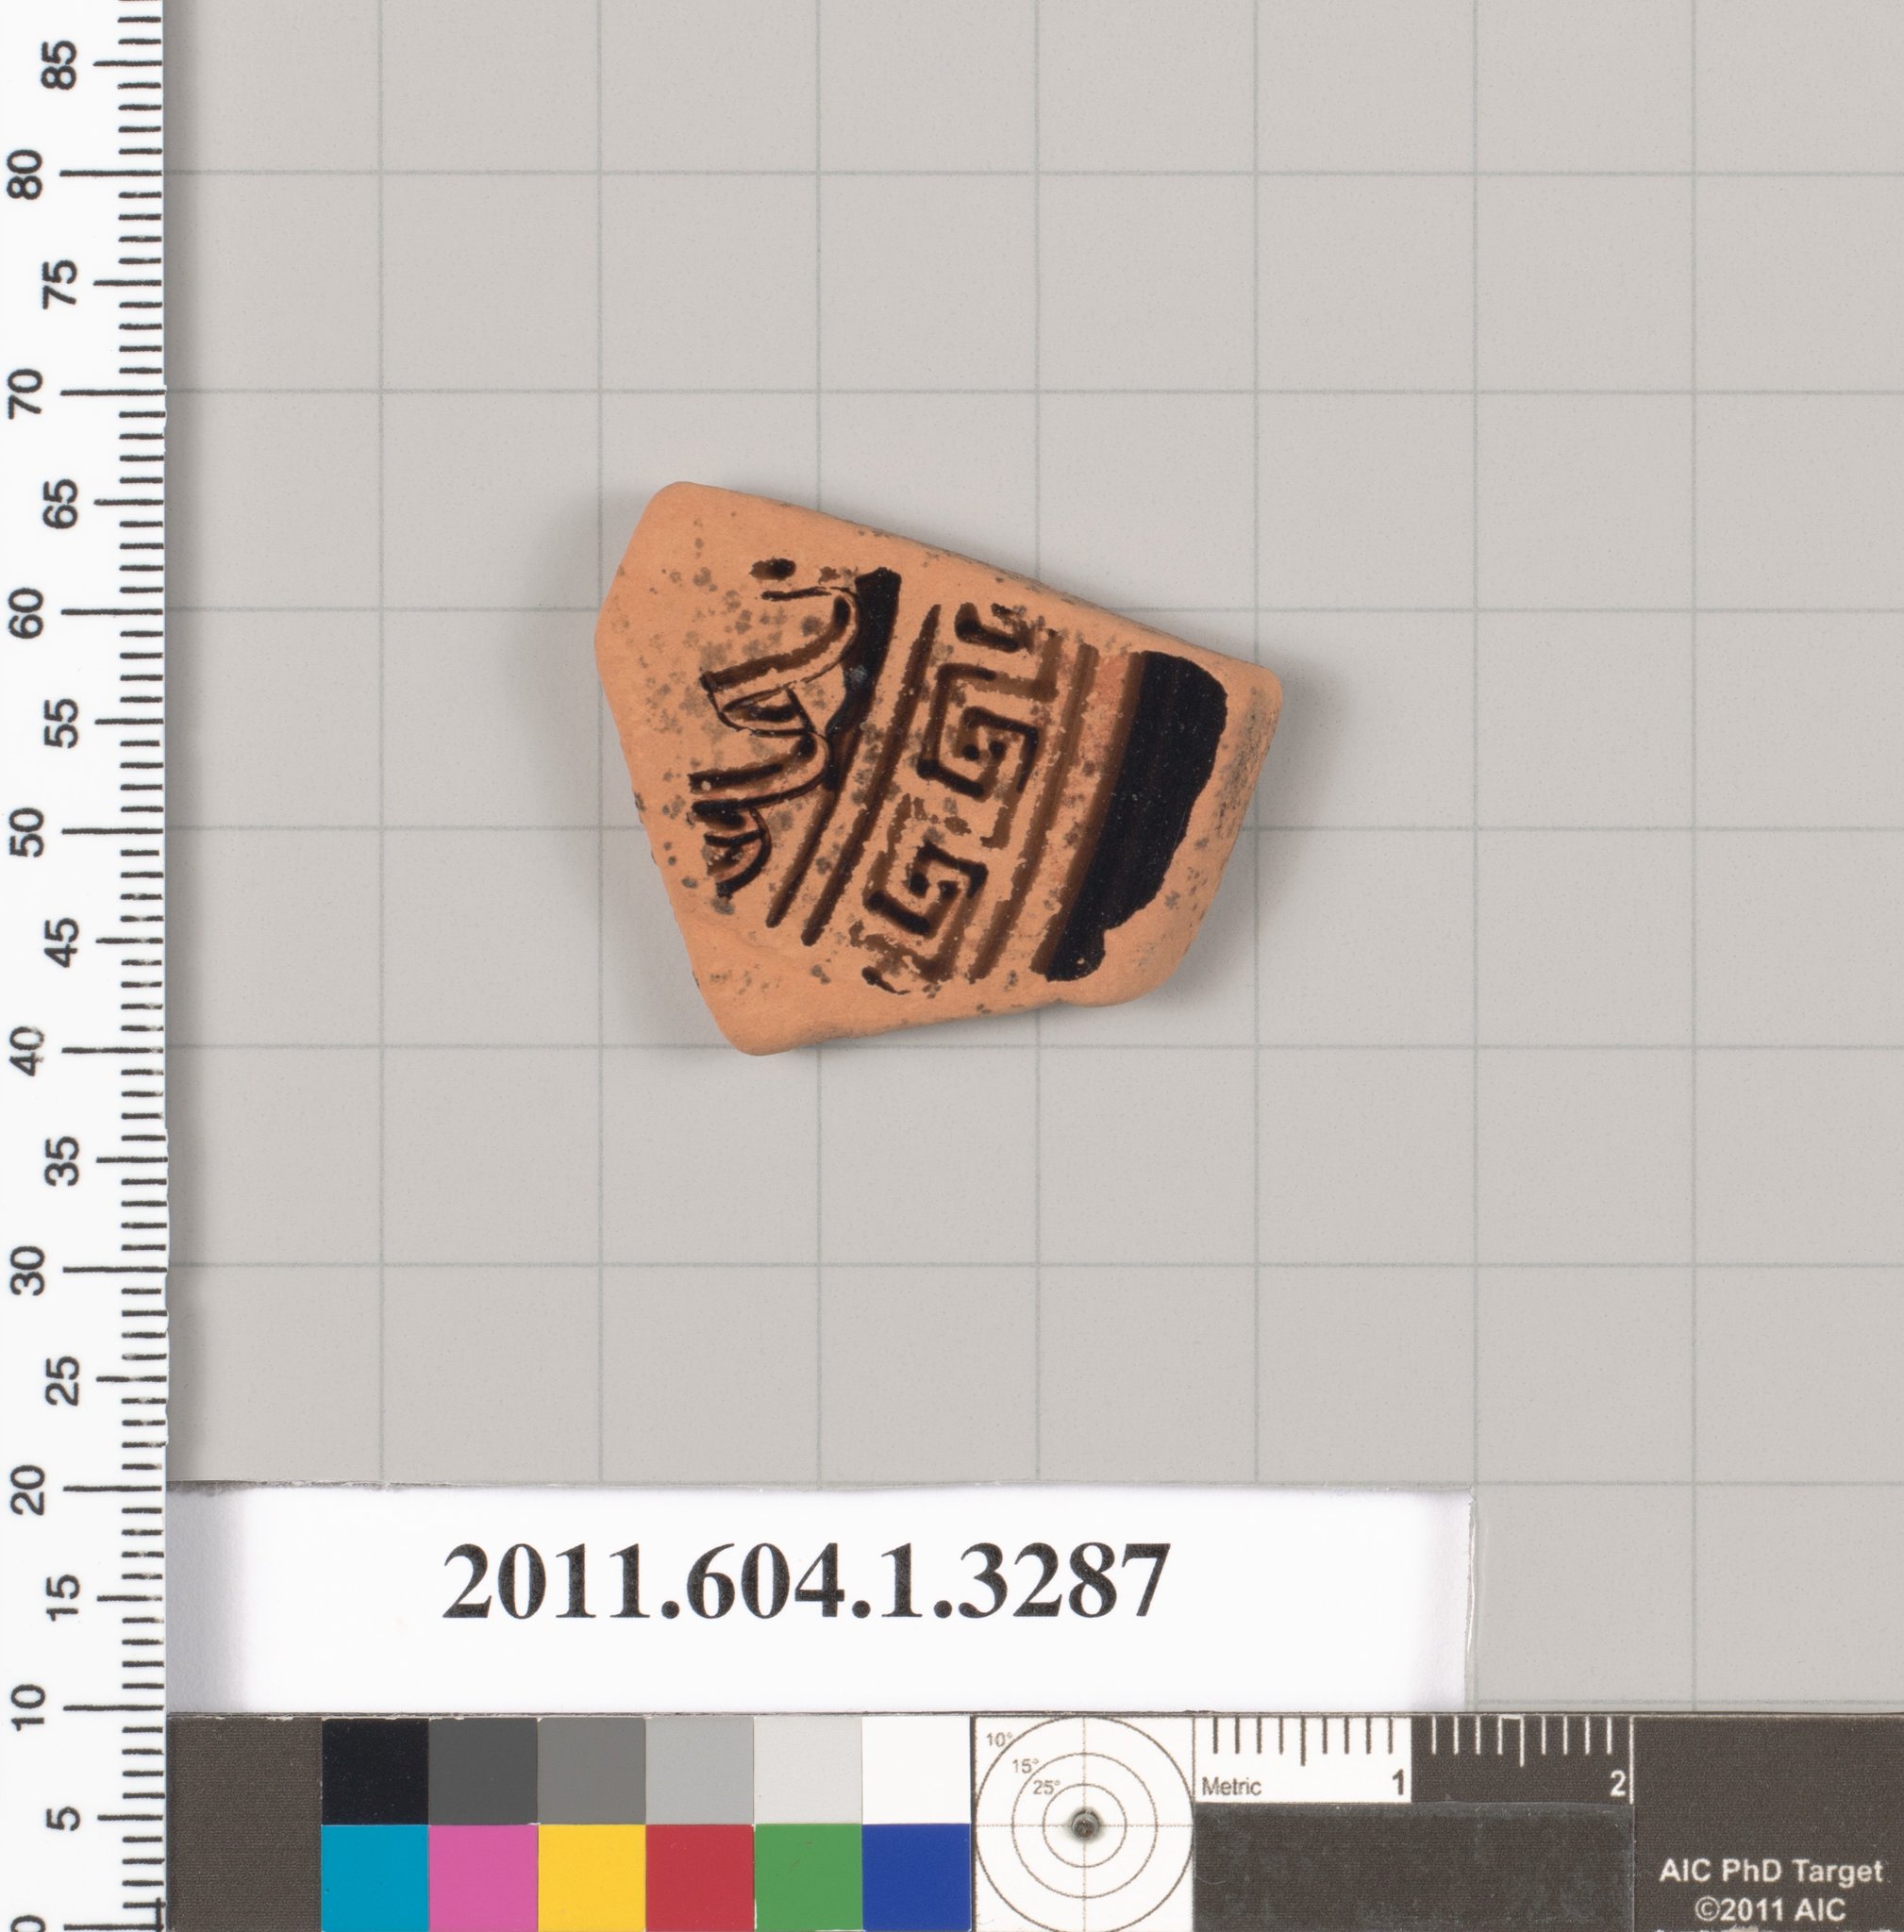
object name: kylix fragment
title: Terracotta fragment of a kylix (drinking cup)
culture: greek, attic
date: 490-480 BCE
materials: terracotta